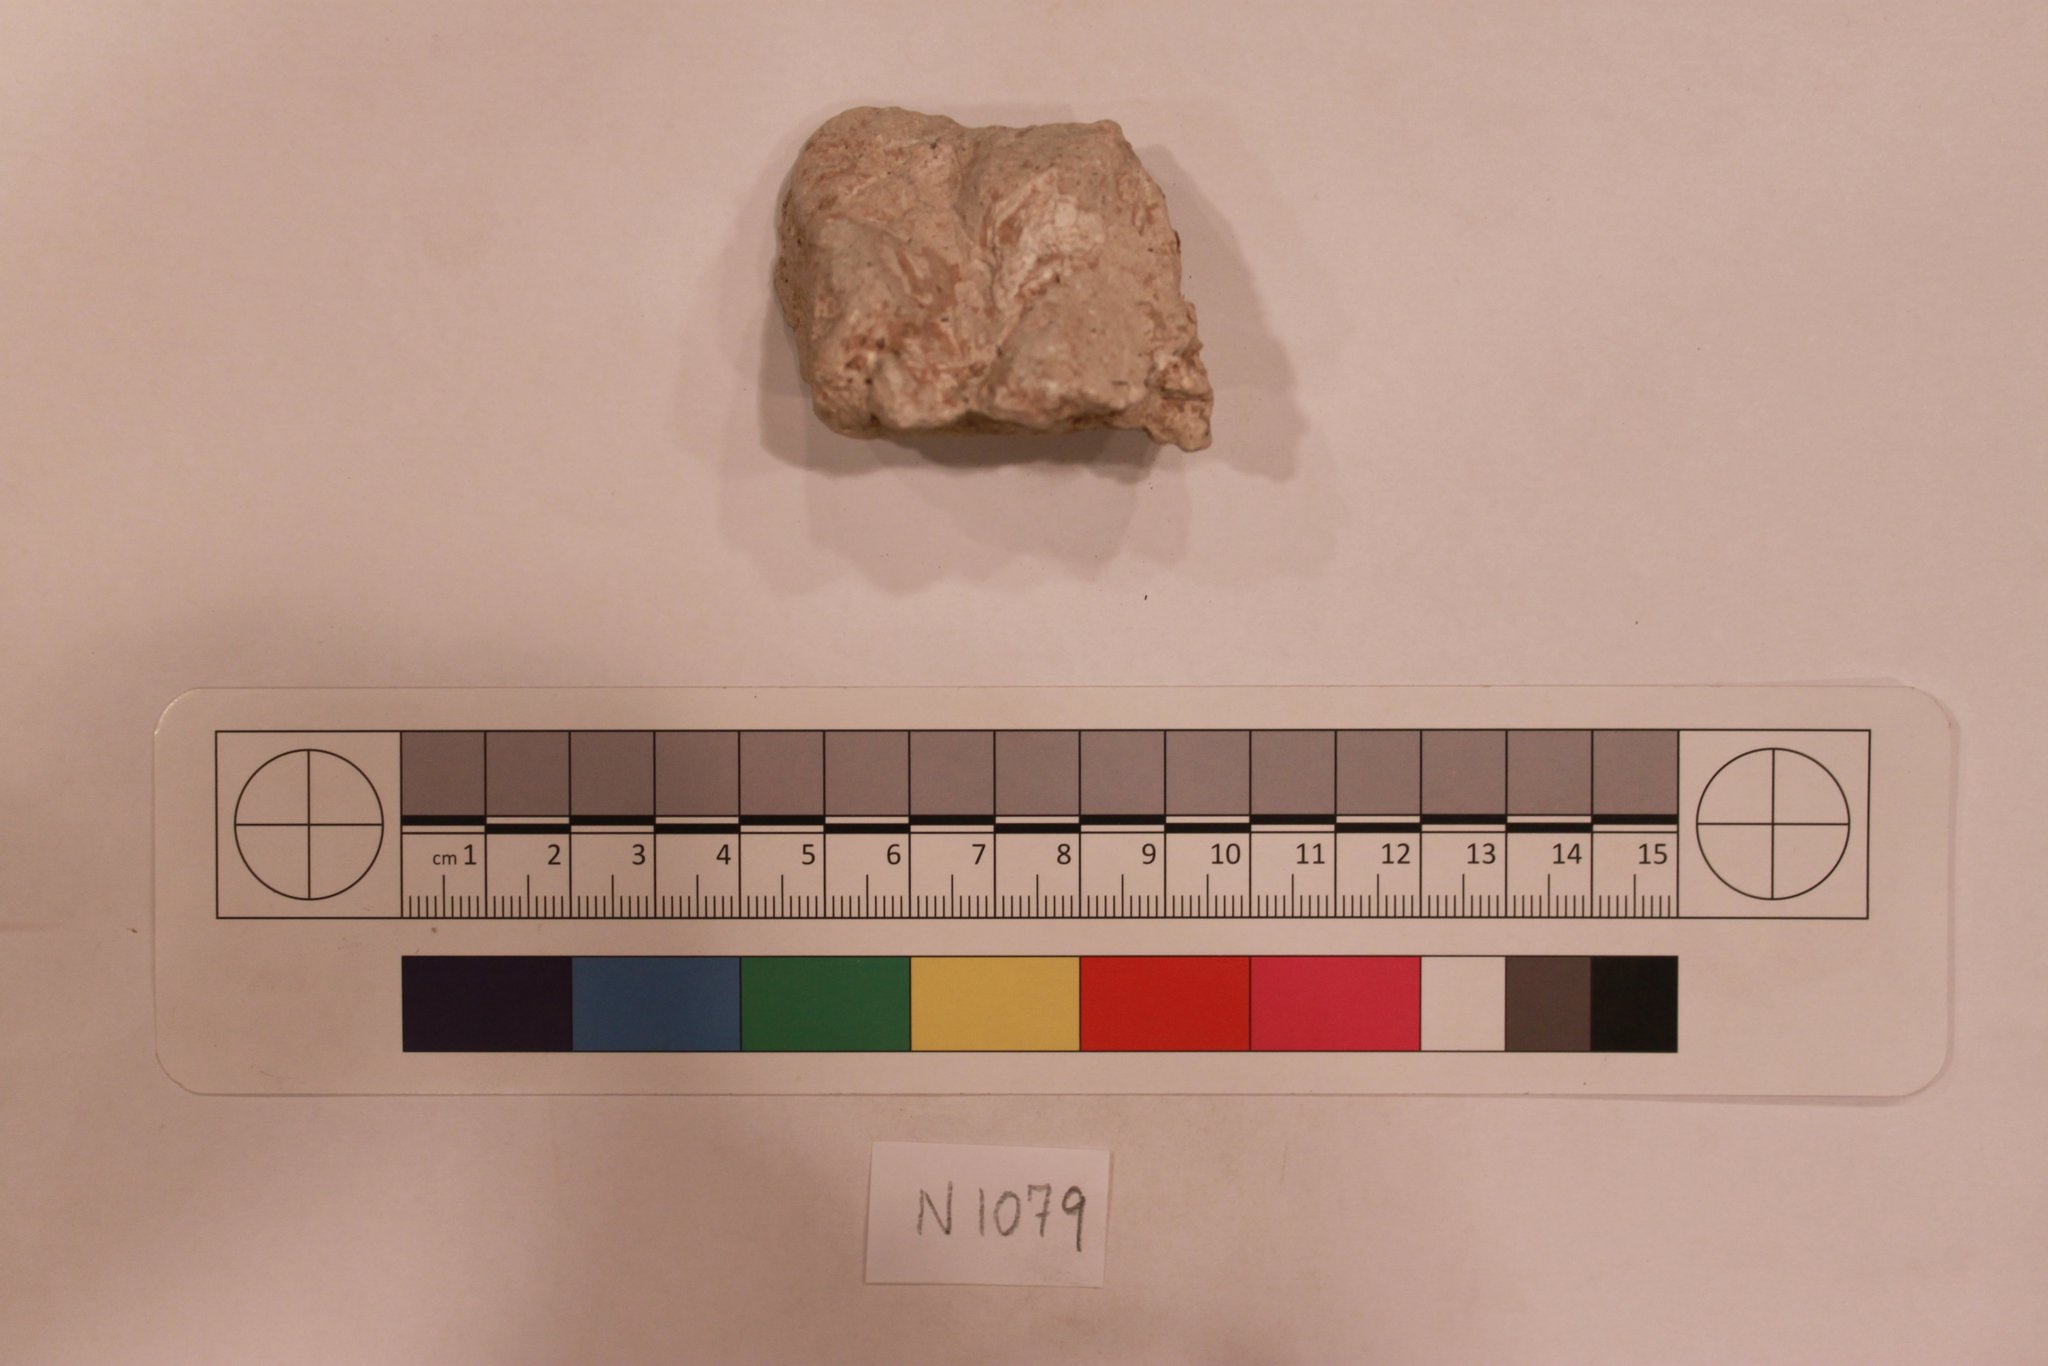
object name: fragment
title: Stucco Fragment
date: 701-1200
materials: plaster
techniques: carving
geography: iran